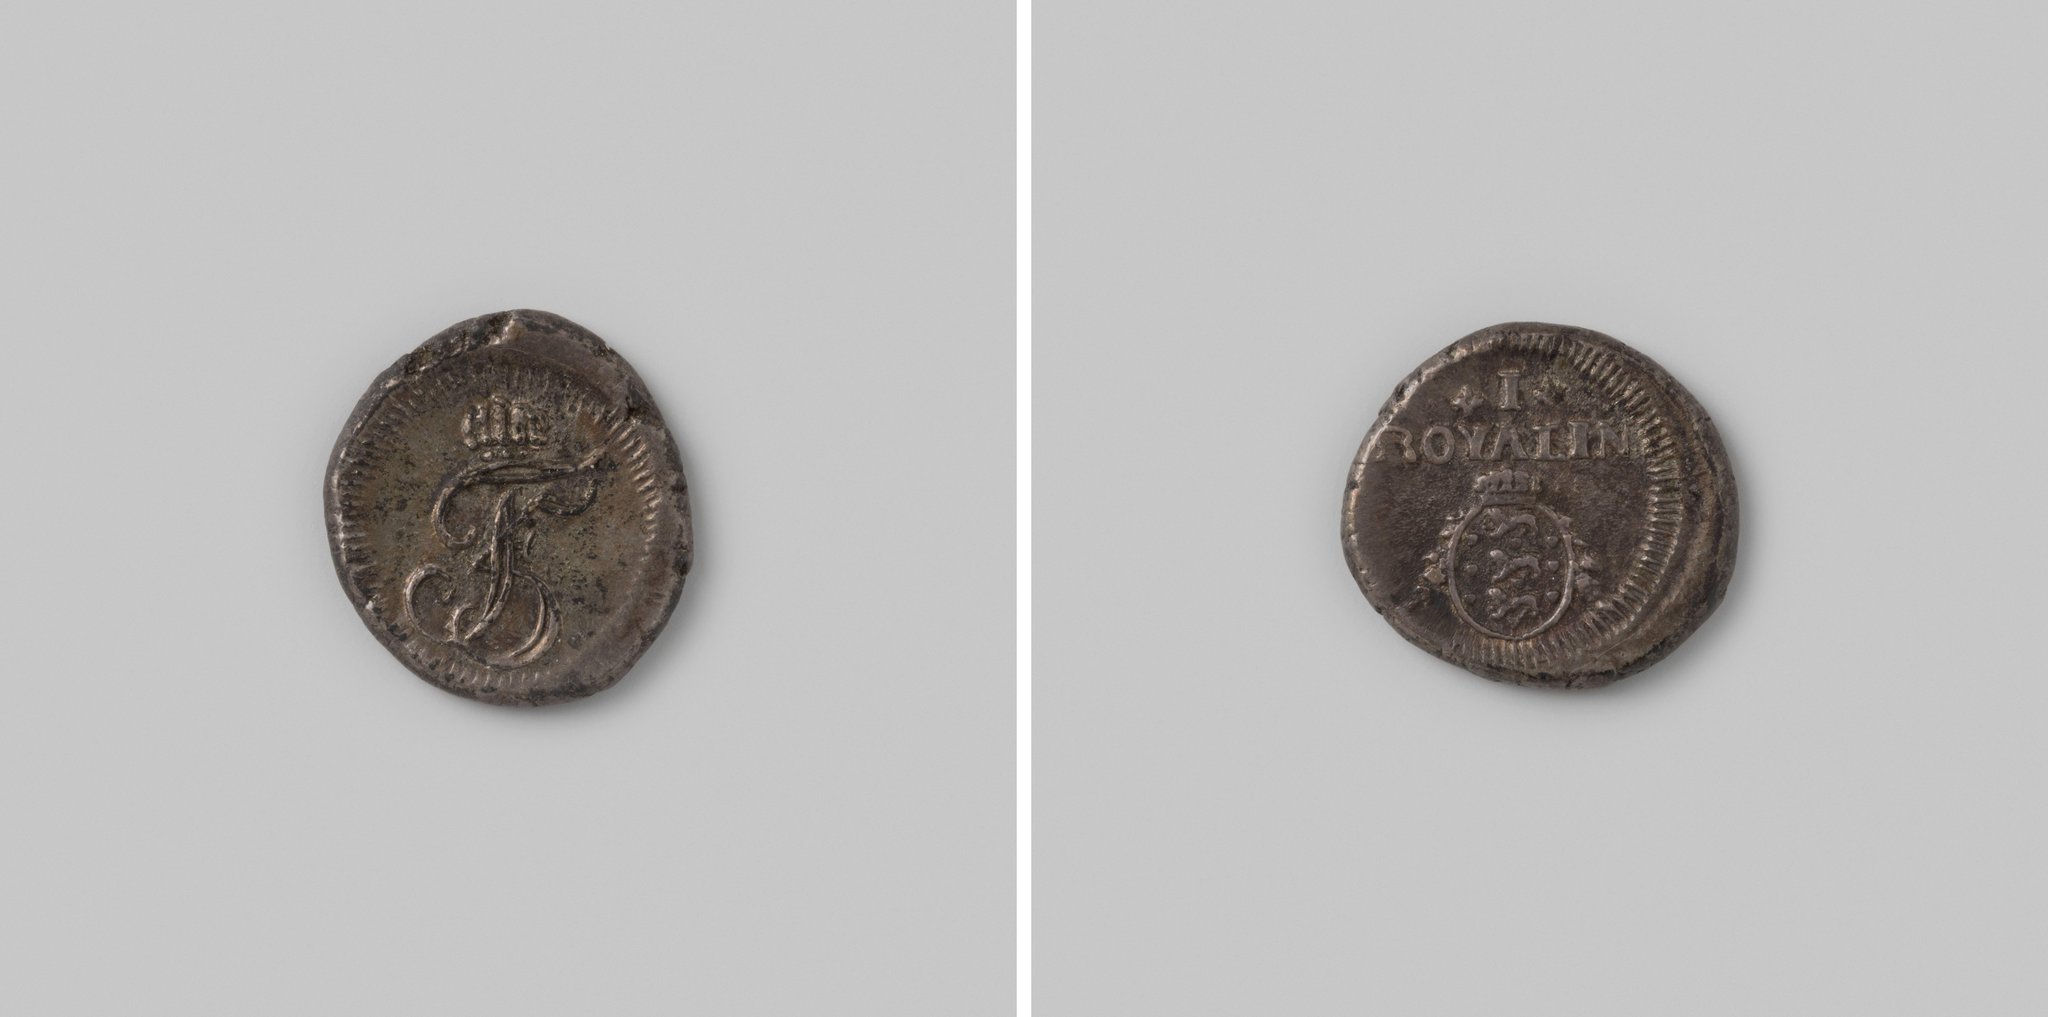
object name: coin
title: Tranquebar, Deens-India, Deense Aziatische Compagnie (DAC) op naam van koning Frederik V, royalin, 1746-1766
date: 1746-1766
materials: silver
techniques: striking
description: Zilveren munt. Voorzijde: gekroond monogram van de koning. Keerzijde: waarde-aanduiding: 1 royalin in twee regels. Daaronder gekroond ovaal Deens wapenschild. Gladde rand.